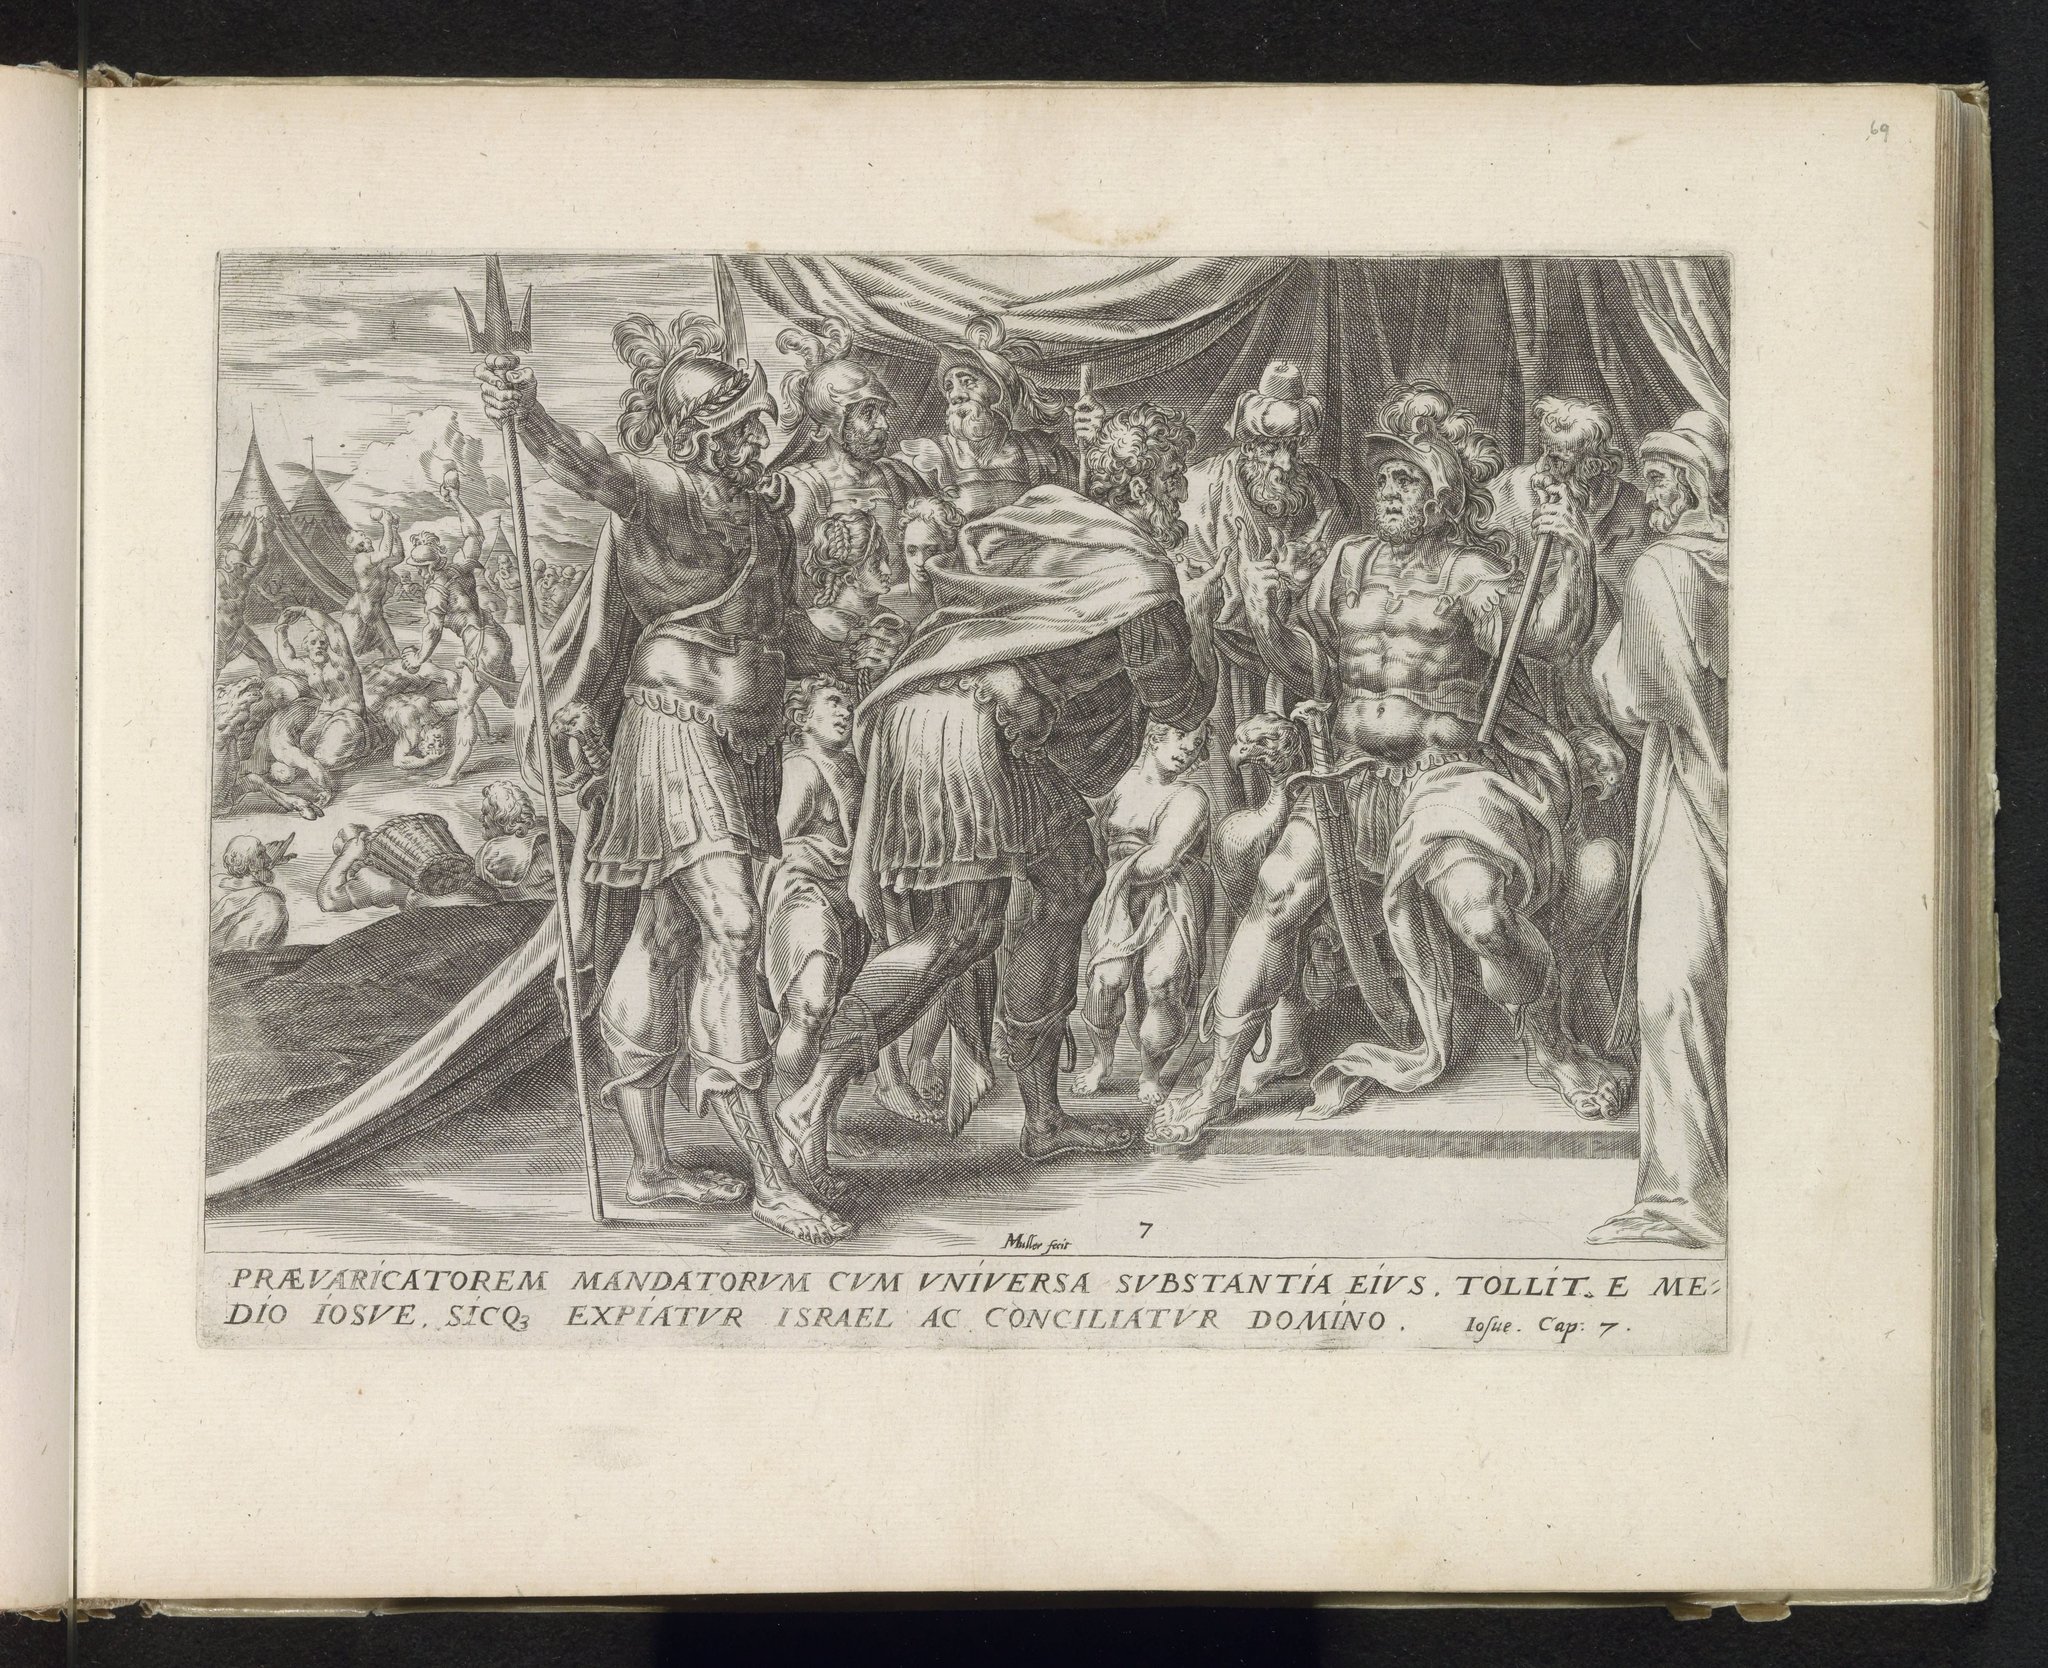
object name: album leaf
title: De geschiedenis van Jozua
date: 1585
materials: paper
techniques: engraving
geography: antwerp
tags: achan and his family are stoned and burned (aftermath of the fall of jericho), achan confesses to have taken from the spoils a garment and some silver and gold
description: Achan wordt voorgeleid aan Jozua, omdat hij oorlogsbuit had gestolen. Op de achtergrond worden Achan en zijn familie gestenigd. Onder de voorstelling een verwijzing in het Latijn naar de Bijbeltekst in Joz. 7. Deze prent maakt deel uit van een album.